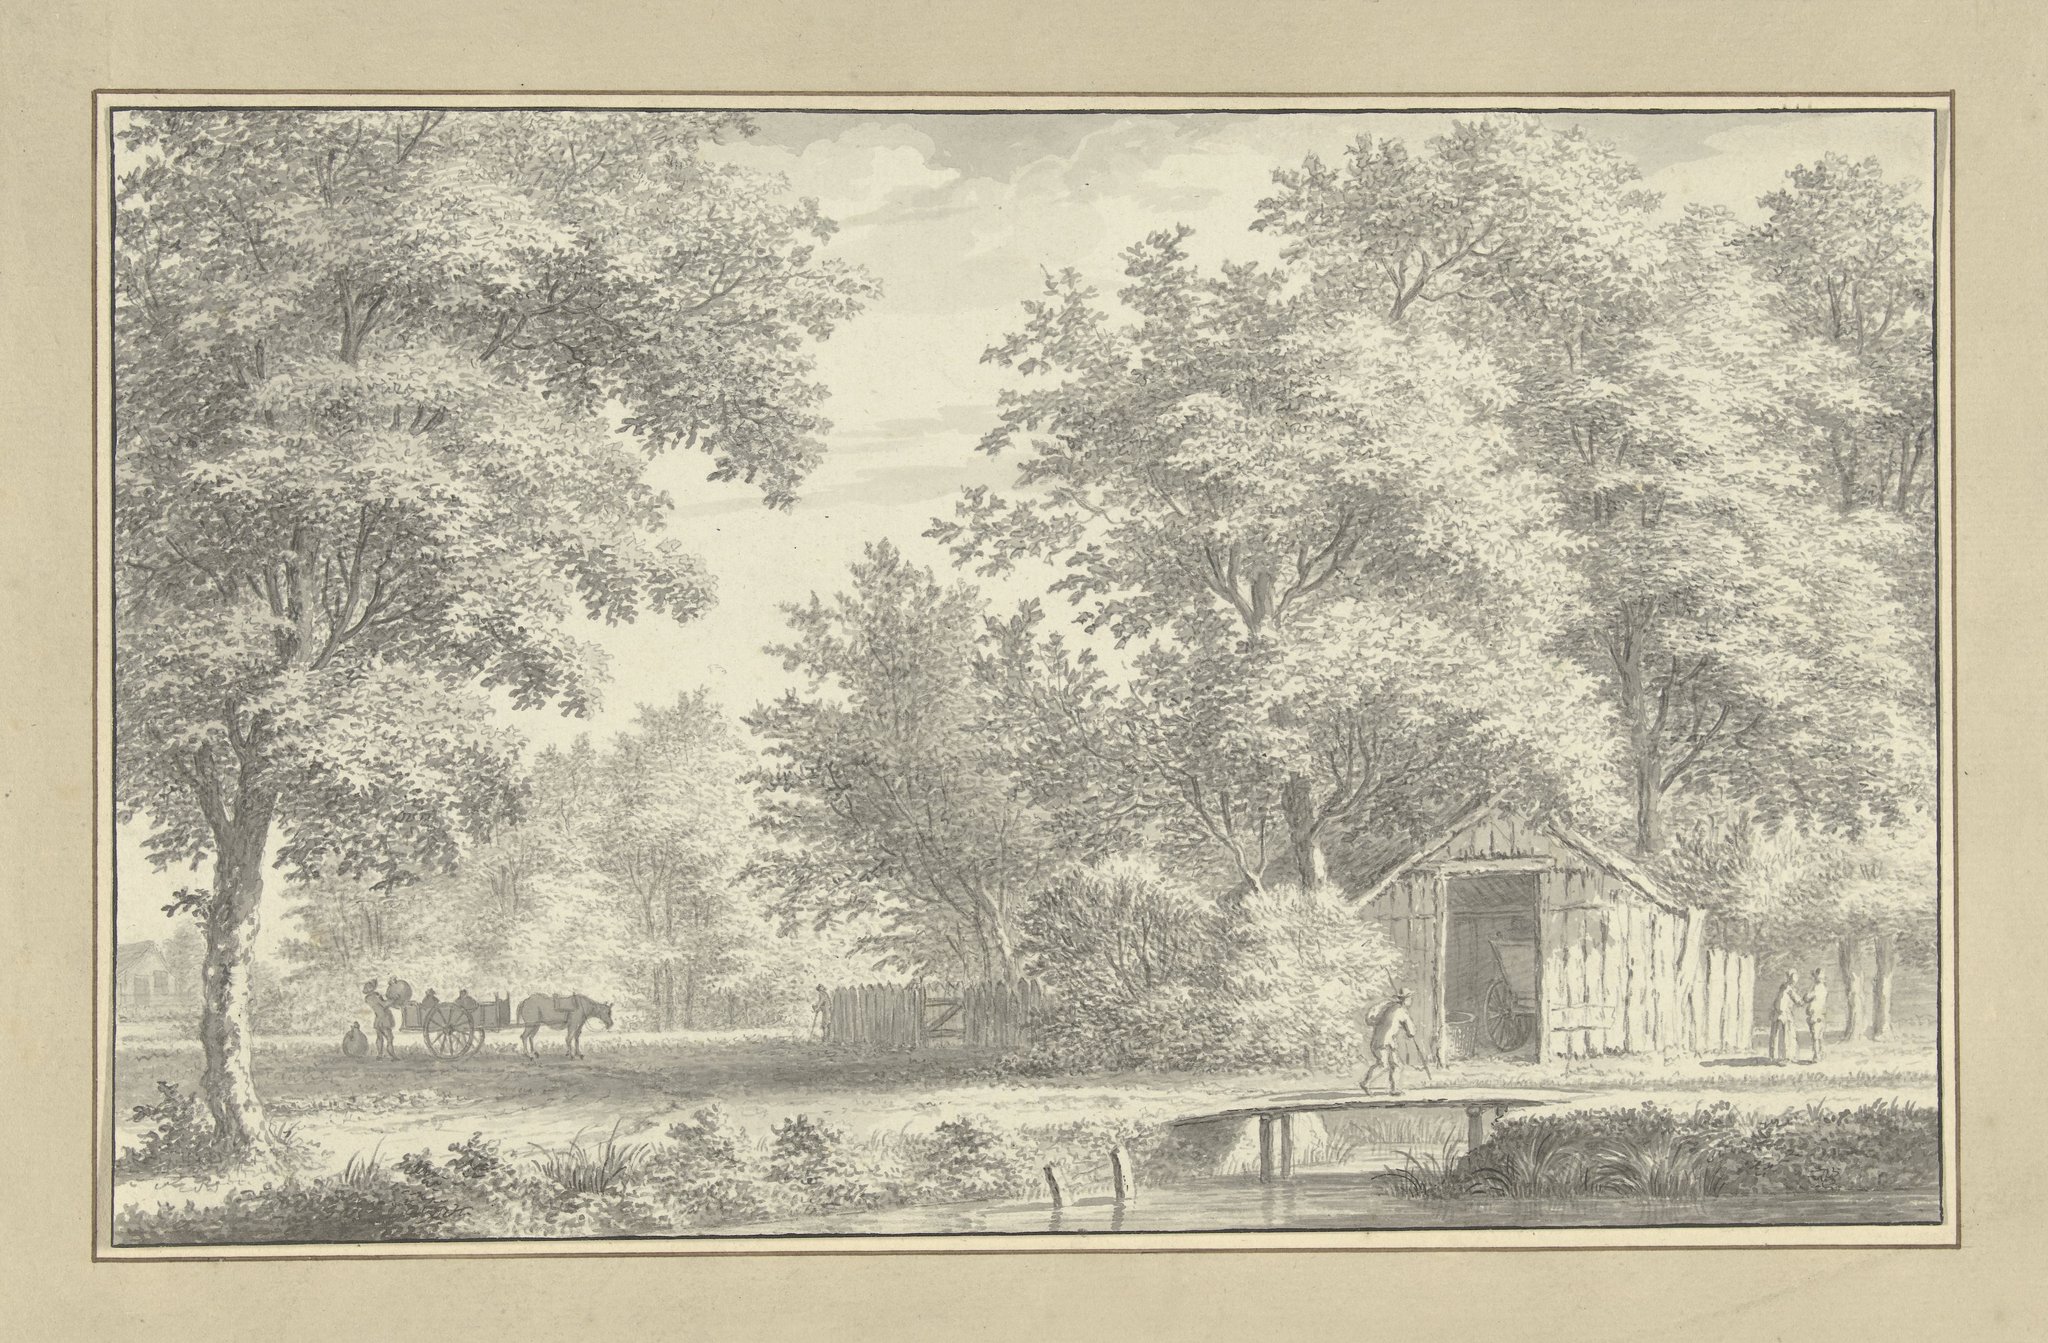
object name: drawing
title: Landschap met schuur tussen bomen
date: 1700-1772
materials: ink, paper, pencil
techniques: brush, pen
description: Landschap met schuur tussen bomen, links wordt een kar geladen.